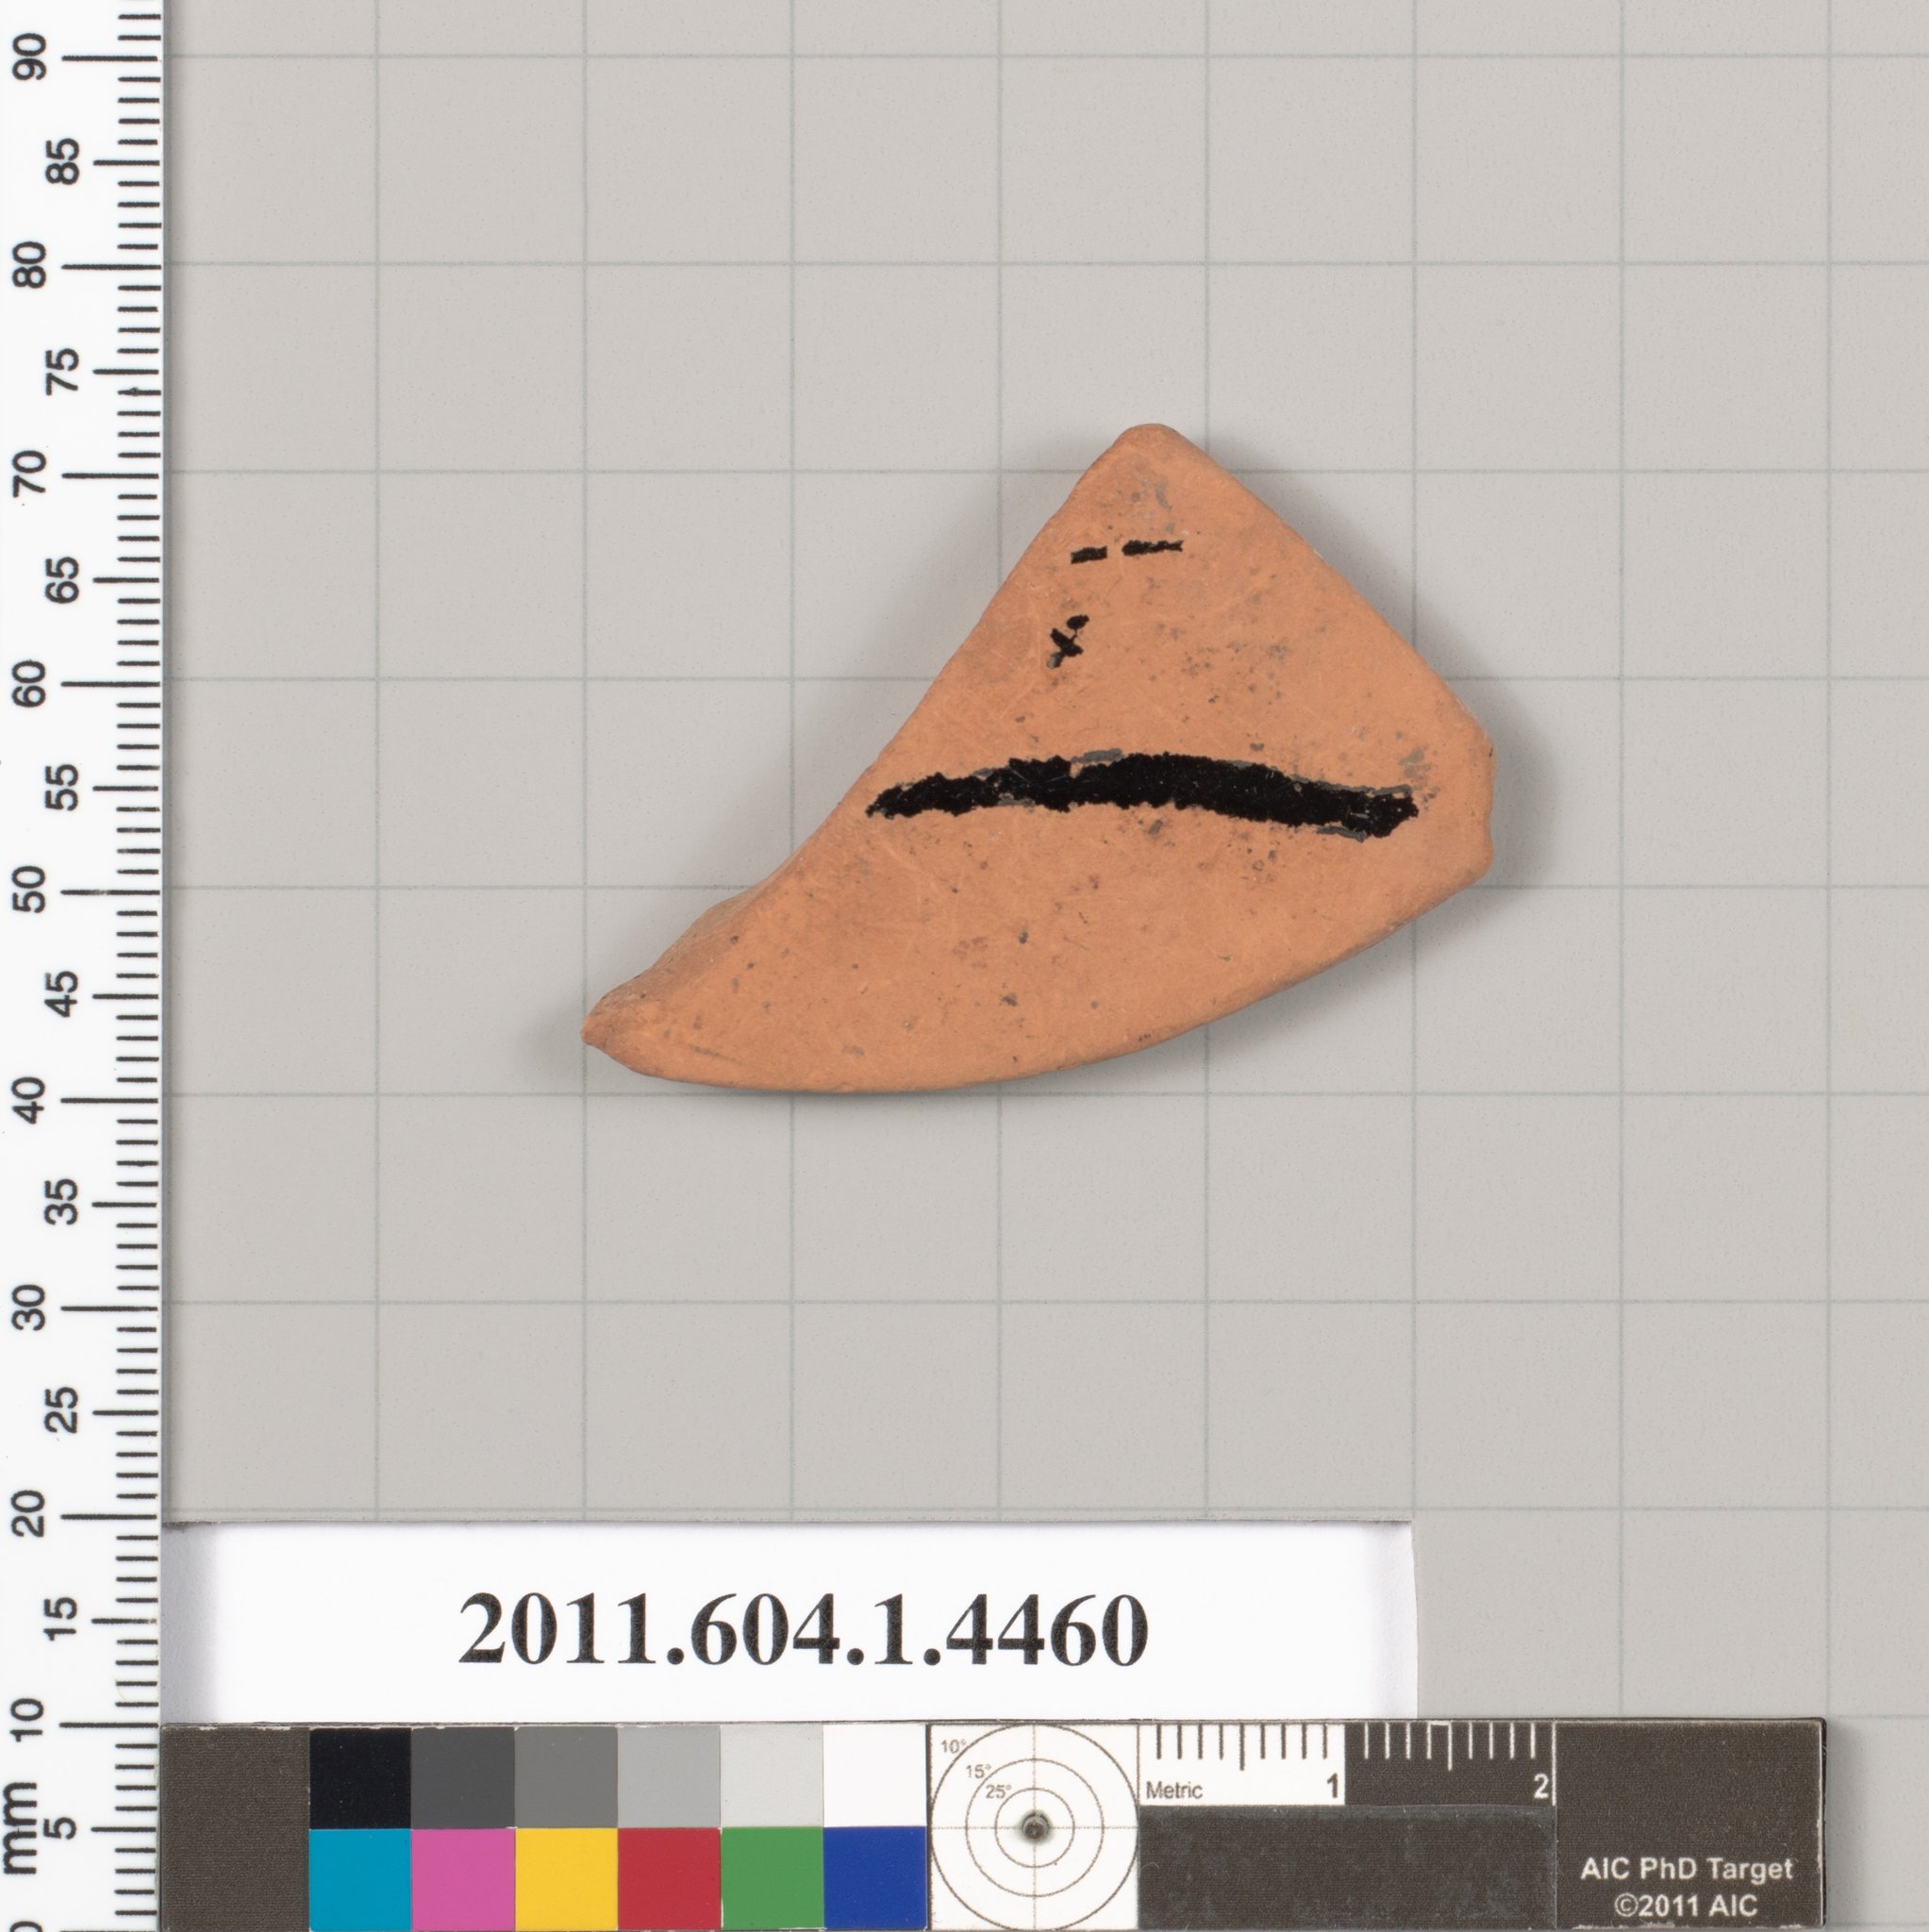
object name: kylix fragment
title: Terracotta fragment of a kylix (drinking cup)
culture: greek, attic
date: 500-451 BCE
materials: terracotta